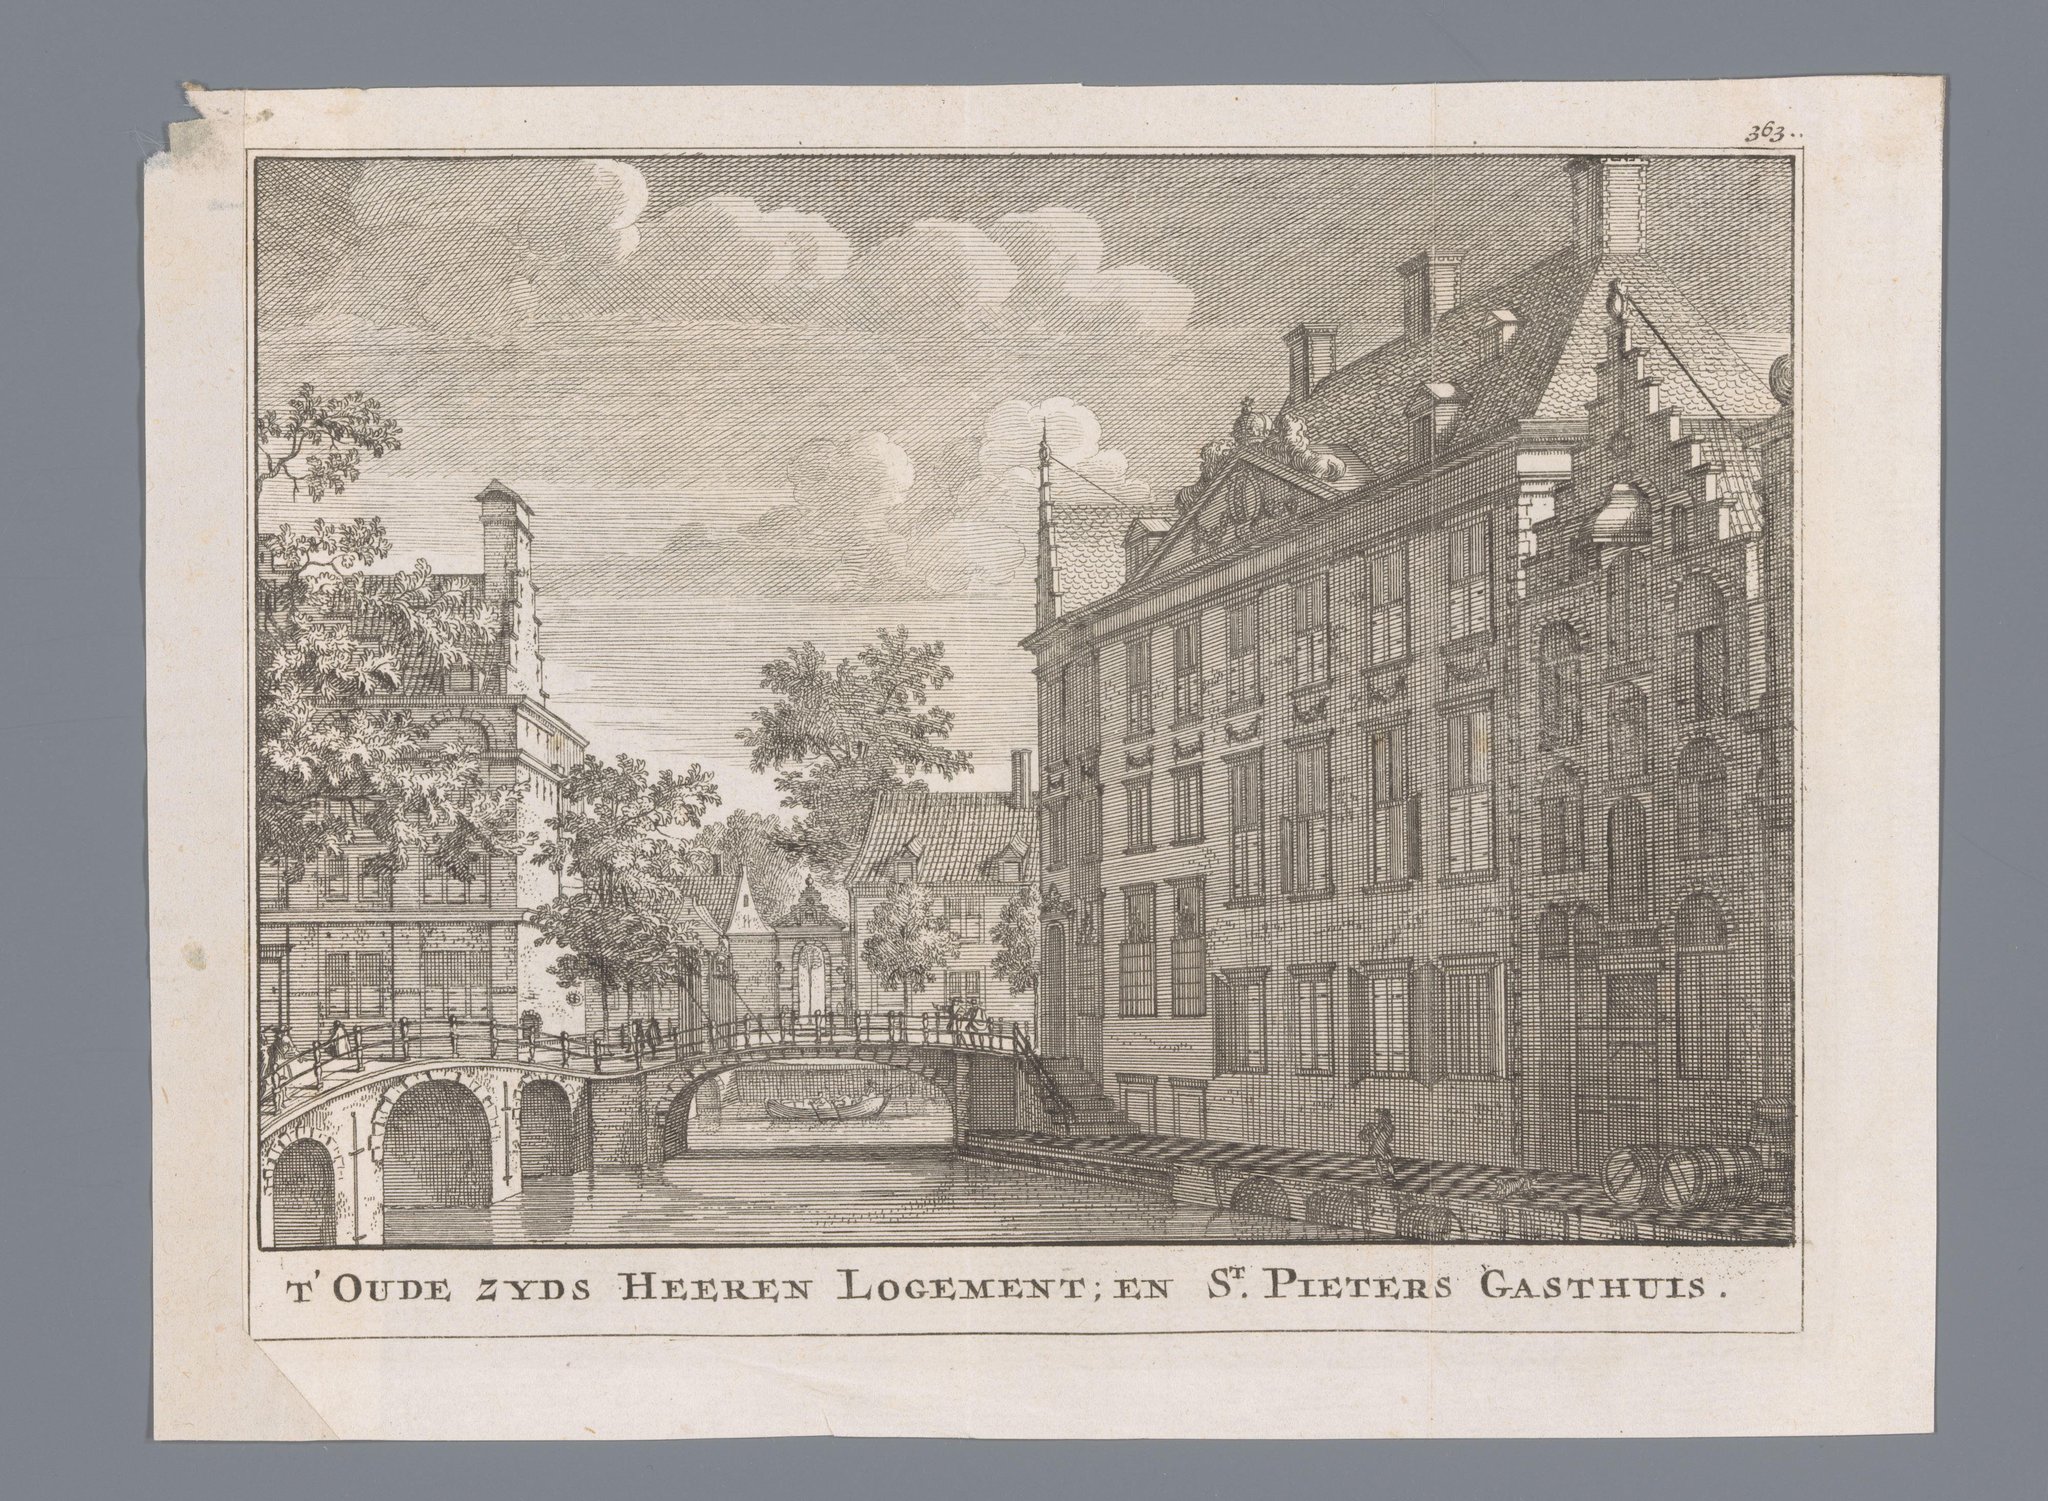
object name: print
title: Gezicht op het Oudezijds Heerenlogement en St. Pietersgasthuis in Amsterdam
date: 1726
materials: paper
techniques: engraving, etching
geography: amsterdam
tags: rowing-boat, canoe, etc., bridge in city across river, canal, etc., hotel, hostelry, inn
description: Prent uit: Hoorn, Nicolaas ten. Wegwyzer door Amsterdam, Zynde eene beknopte verhandeling van desselfs eerste opkomst, vergrootingen, en teegenwoordigen staat (…). Tweede druk. Amsterdam: Nicolaas ten Hoorn, 1726, p. 363. En in de latere edities (Amsterdam: erven J. Ratelband & Co, 1737, en Amsterdam: Pieter Meyer, 1751). In de eerste editie heeft deze prent een andere plek in het boek, en een ander nummer (343).